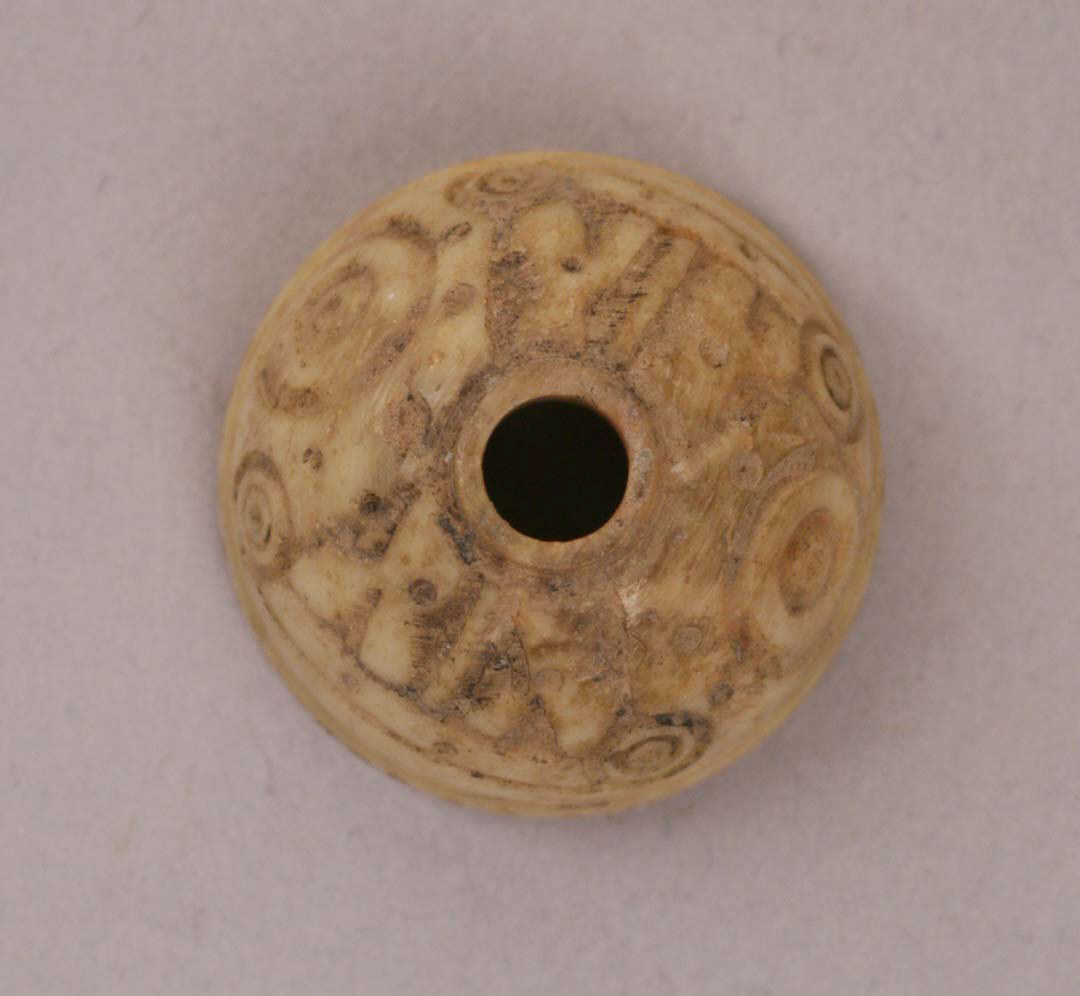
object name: button or bead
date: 801-1000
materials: bone, paint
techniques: incising, inlay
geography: iran